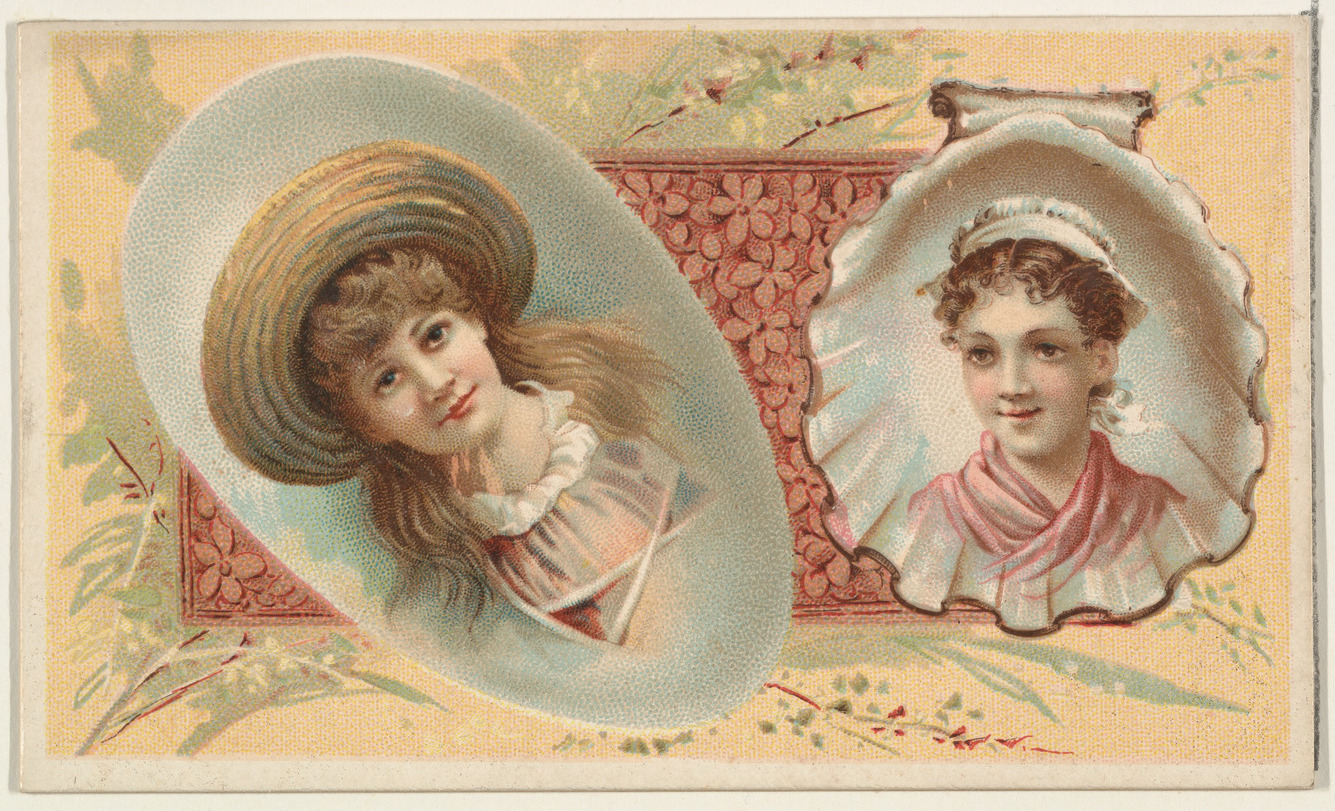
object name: print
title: Seashell, from the Miniature Novelties series (N120) issued by Duke Sons & Co. to promote Honest Long Cut Tobacco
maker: w. duke, sons & co.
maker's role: publisher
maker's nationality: american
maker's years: 1870-1920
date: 1891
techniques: color lithograph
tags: women,shells